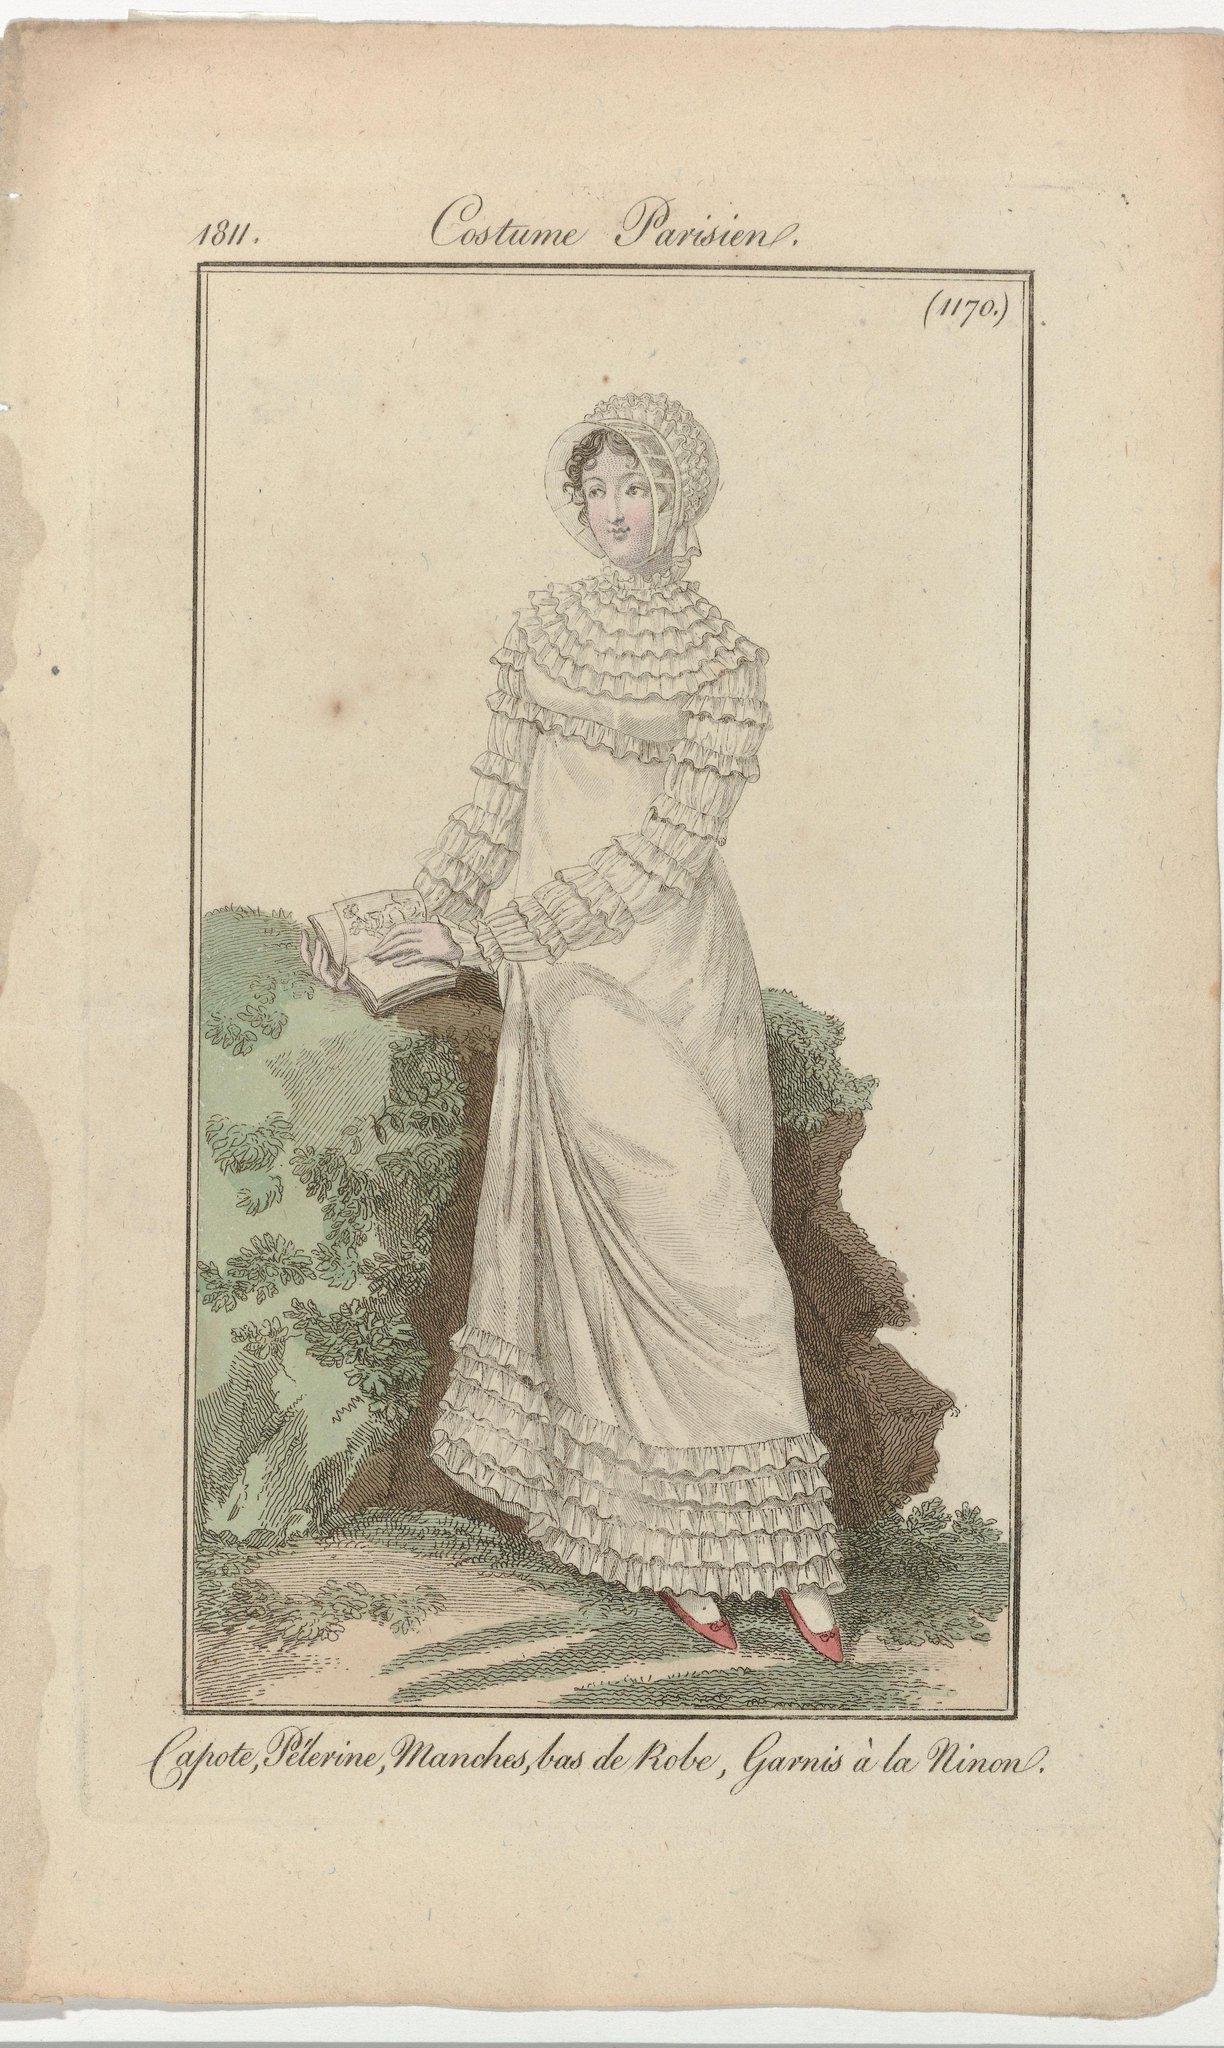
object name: fashion print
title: Journal des Dames et des Modes, Costume Parisien, 10 septembre 1811, (1170): Capote, Pélerine, Manches (...)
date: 1811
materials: paper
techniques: engraving, hand coloring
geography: paris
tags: head-gear (capote) (+ women's clothes), ornamental parts of clothing (+ women's clothes), clothing for the upper part of the body (pelerine) (+ women's clothes), fashion plates, shoes, sandals (+ women's clothes), dress, gown (+ women's clothes), book - mm - book open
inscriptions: title: ‘Costume Parisien.’, caption: ‘Capote, Pélerine, manches, bas de Robe, garnis à la Ninon’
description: Vrouw, zittend op een steen, gekleed in een japon met pelerine en mamelukkenmouwen. Onderkant versierd 'à la Ninon'. Op het hoofd een 'capote'. Platte schoenen met strikken. Geopend boek in de handen. De prent maakt deel uit van het modetijdschrift Journal des Dames et des Modes, uitgegeven door Pierre de la Mésangère, Parijs, 1797-1839.